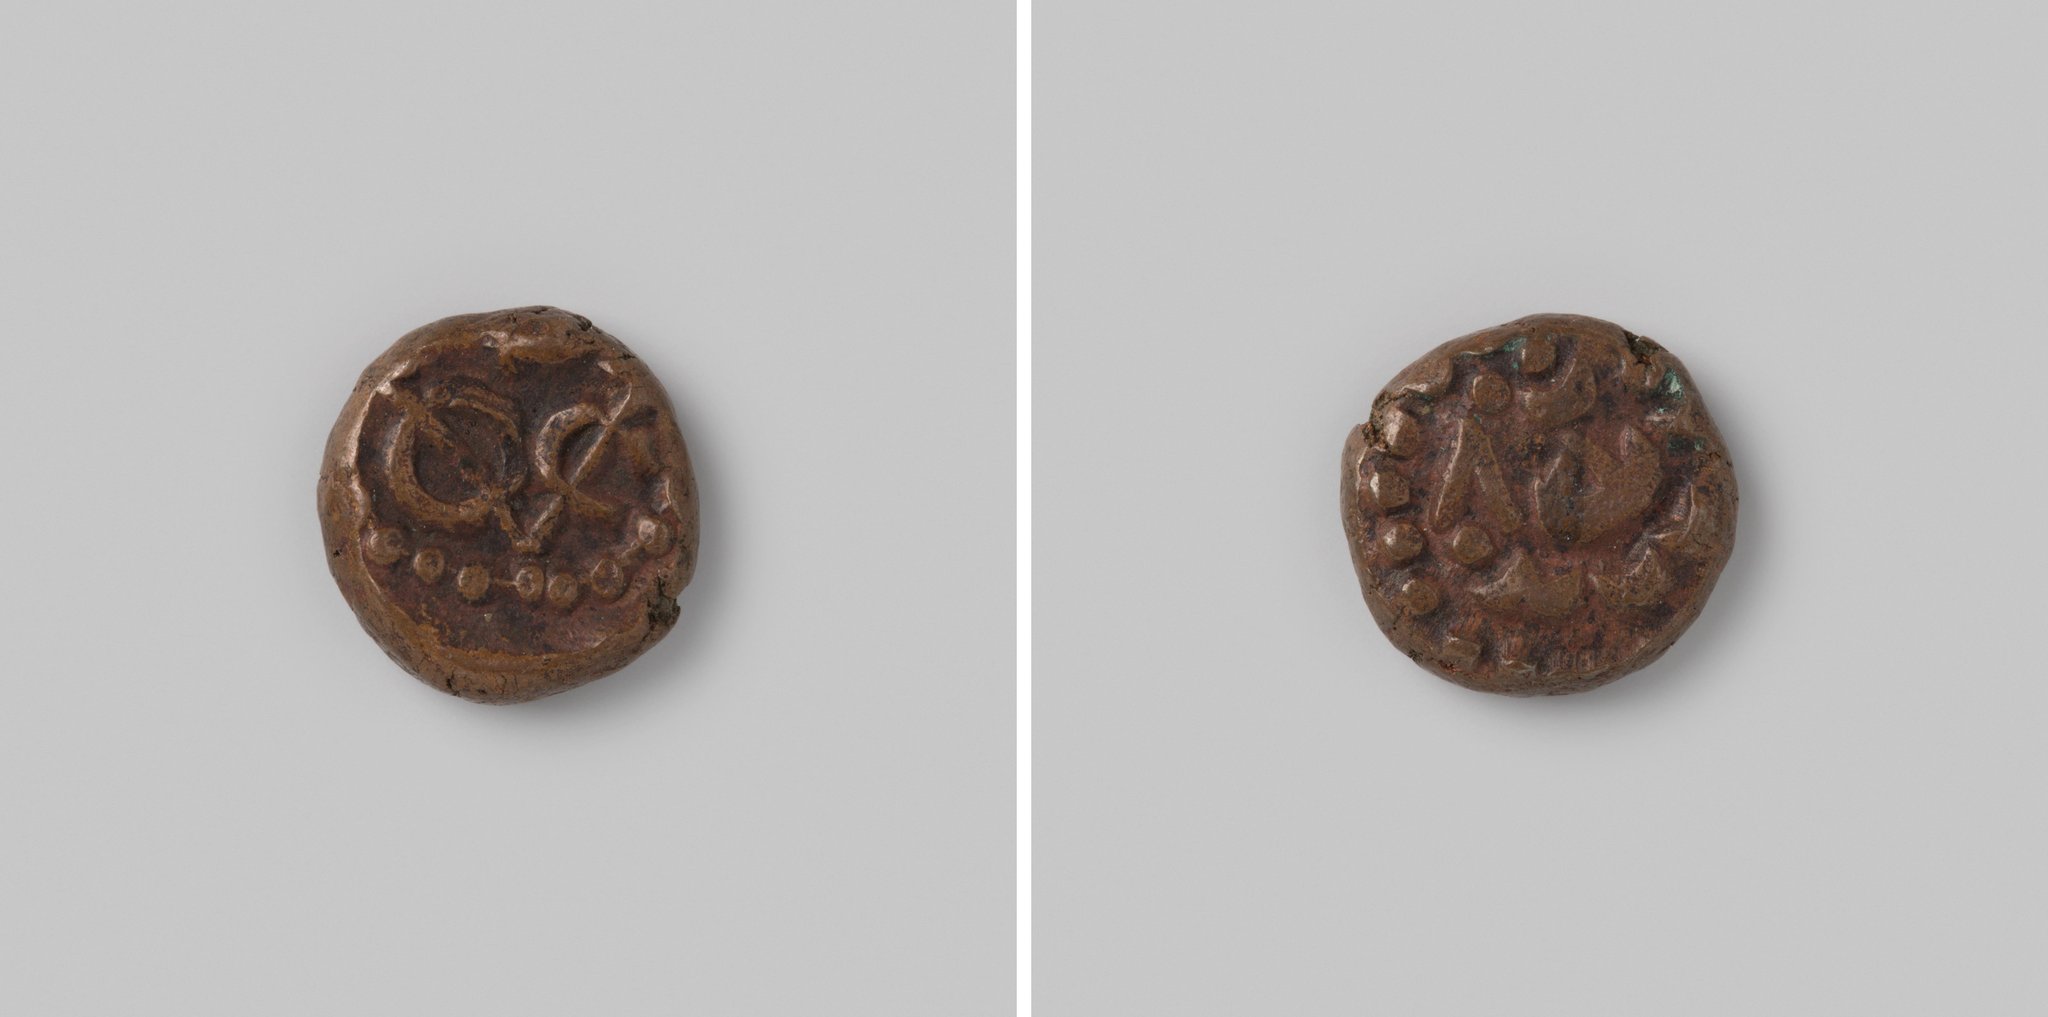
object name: coin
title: VOC, Paliakate, Voor-Indië, kas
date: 1650-1700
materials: copper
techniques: striking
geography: paliacatta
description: Koperen munt. Voorzijde: monogram van de VOC, waarboven gekantelde letter P. Keerzijde: drieregelig opschrif tin Arabische lettertekens. Gladde rand.